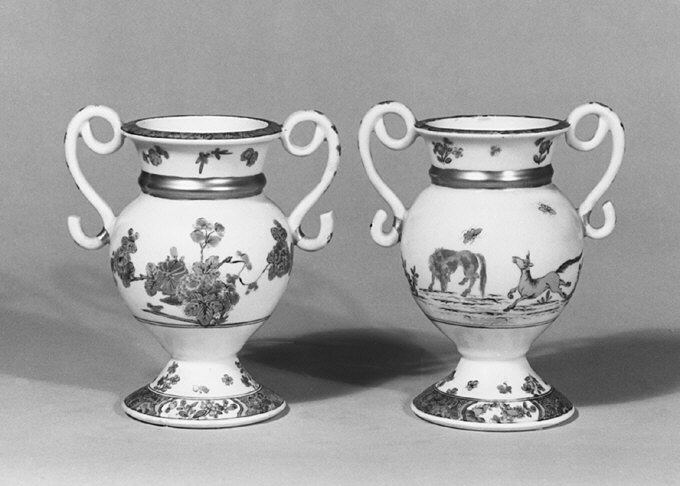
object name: vase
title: Vase (one of a pair)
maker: meissen manufactory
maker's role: manufactory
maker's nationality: german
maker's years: 1710-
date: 1735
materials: hard paste porcelain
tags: animals,insects,flowers